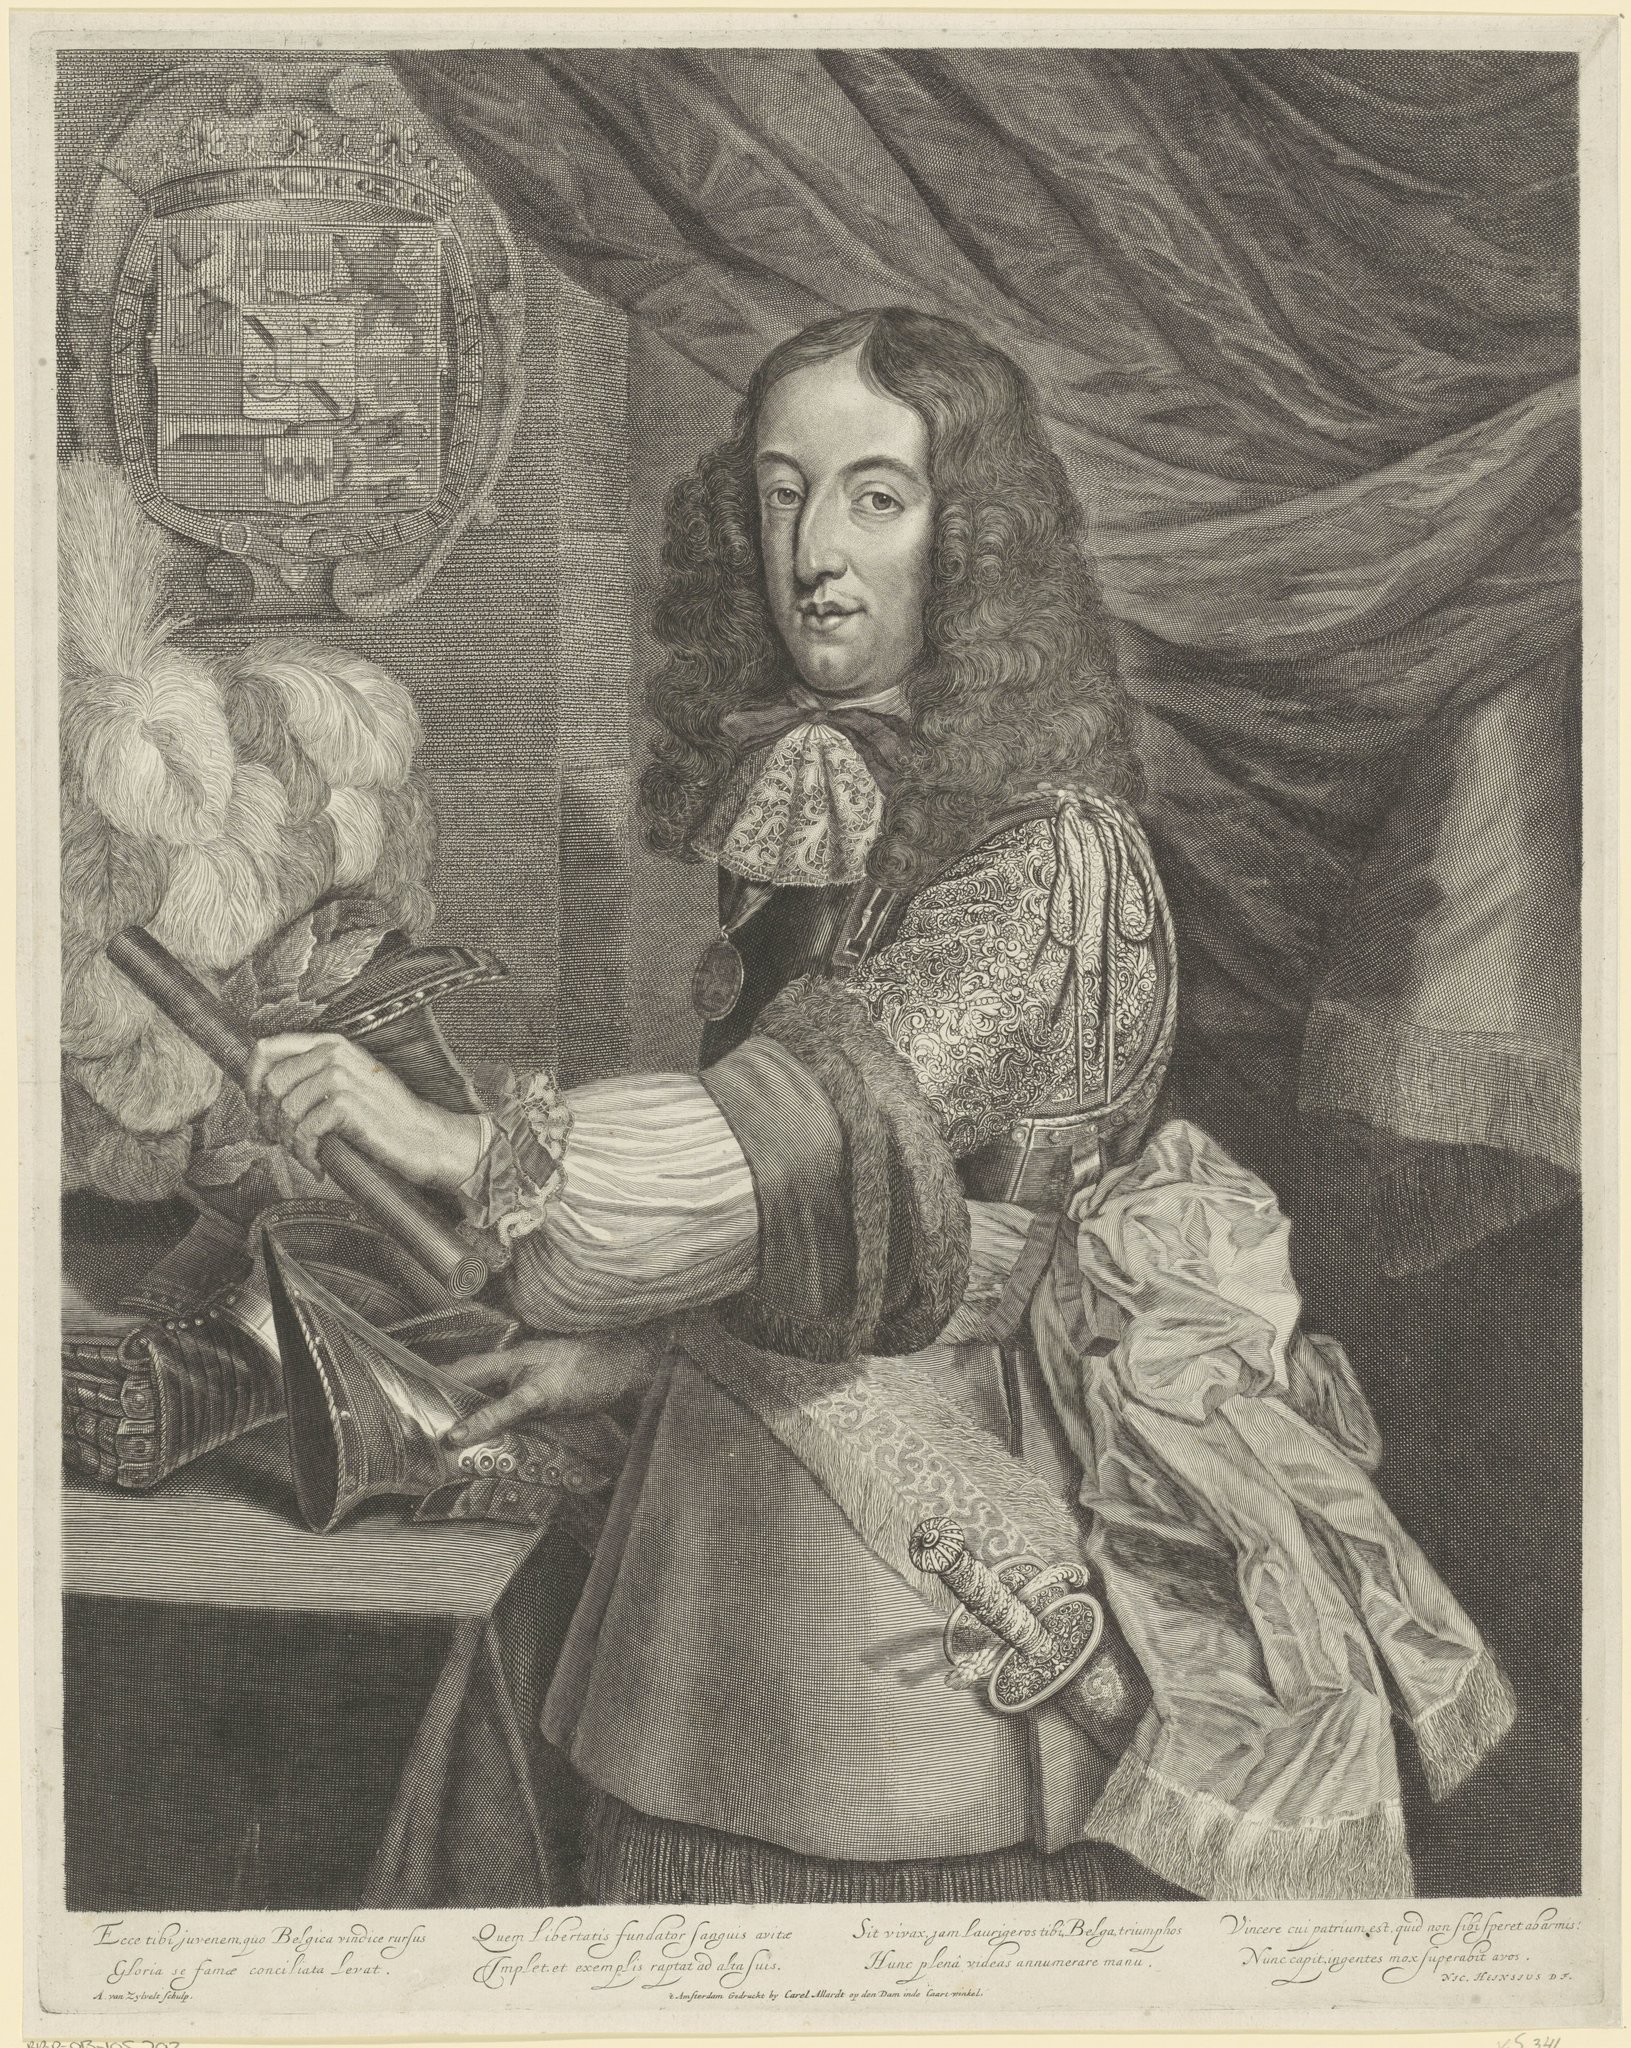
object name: print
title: Portret van Willem III, prins van Oranje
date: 1673-1709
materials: paper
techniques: engraving, etching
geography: amsterdam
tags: william iii (prince of orange and king of england, scotland, and ireland), knighthood order (garter) - insignia of a knighthood order, e.g.: badge, chain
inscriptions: collector's mark: Lugt 963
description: Portret van Willem III. Hij staat in een vertrek naast een tafel, daarop de handschoenen en helm van zijn harnas. In zijn linkerhand een commandostaf. Linksboven zijn wapen met een kroon, gedecoreerd met de Kousenband en het devies van de Orde van de Kousenband. In de ondermarge vier kolommen met elk twee regels Latijnse tekst.